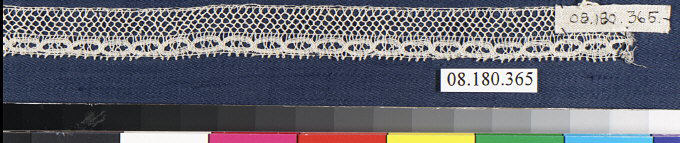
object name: piece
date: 1701-1800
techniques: lace